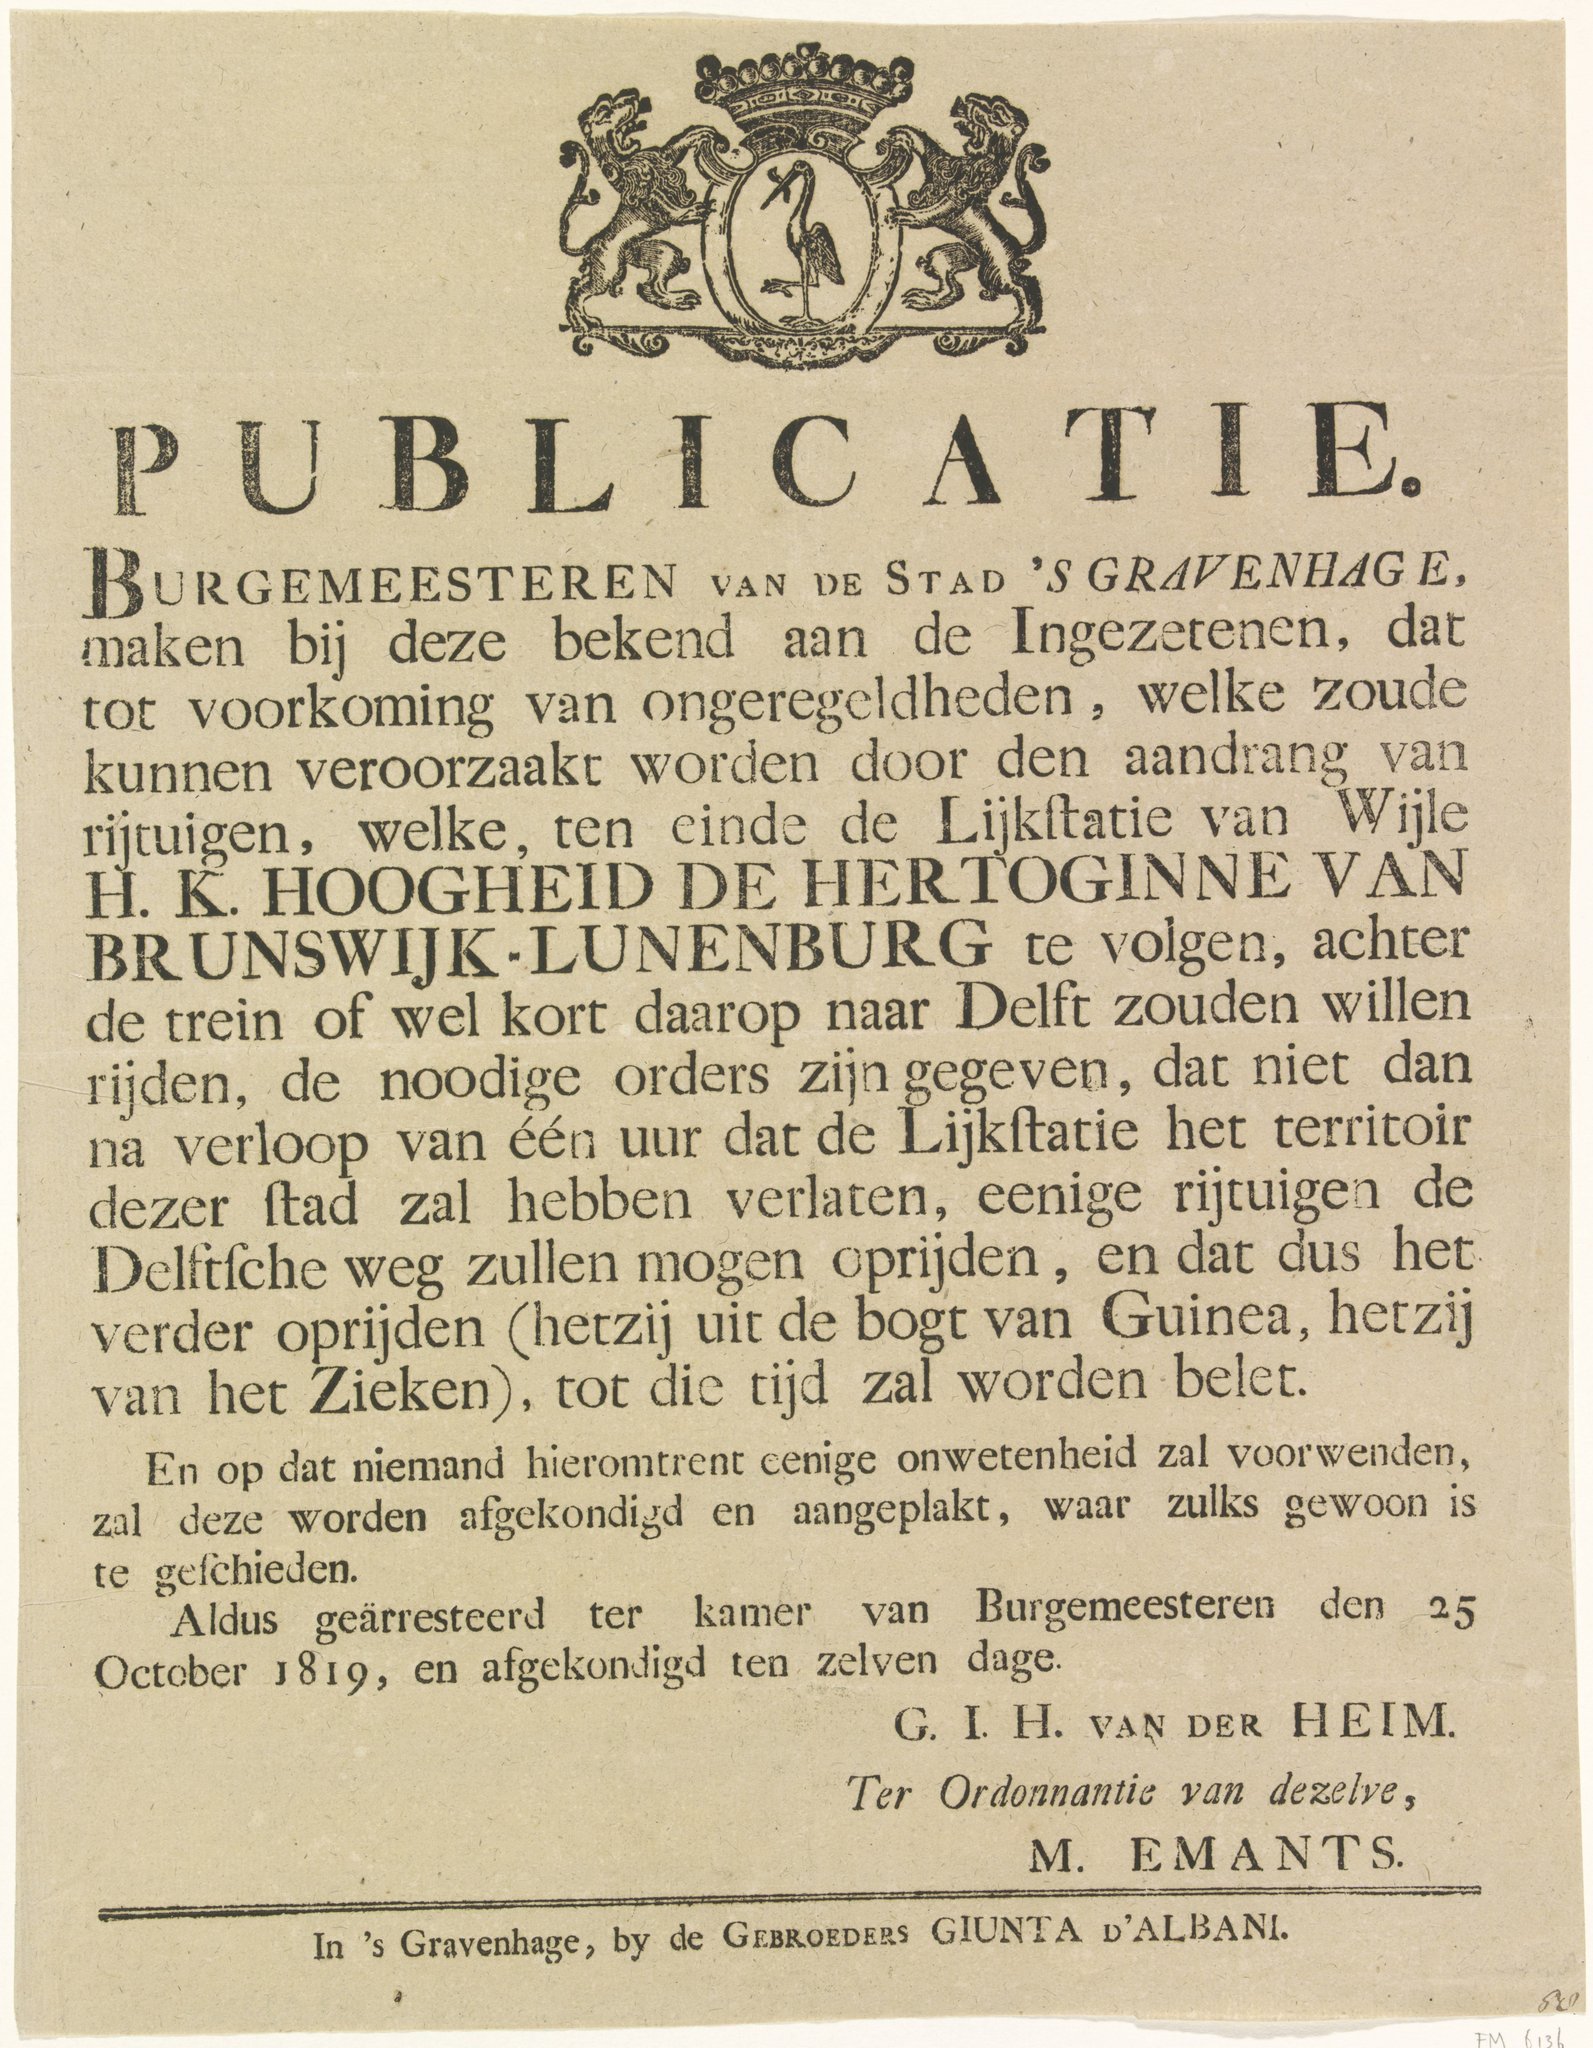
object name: text sheet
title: Bekendmaking van de begrafenisplechtigheid van prinses Louise van Oranje-Nassau, 1819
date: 1819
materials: paper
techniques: letterpress printing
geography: the hague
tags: louise (prinses van oranje-nassau), the hague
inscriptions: collector's mark: Lugt 2228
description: Publicatie met de bekendmaking van de afsluiting van een weg wegens de begrafenisstoet op 26 oktober te Den Haag van Frederica Louisa Wilhelmina, prinses van Oranje-Nassau, weduwe van hertog Karl George August van Brunswijk, overleden op 15 oktober 1819. Tekst met bovenaan het wapen van de stad Den Haag.